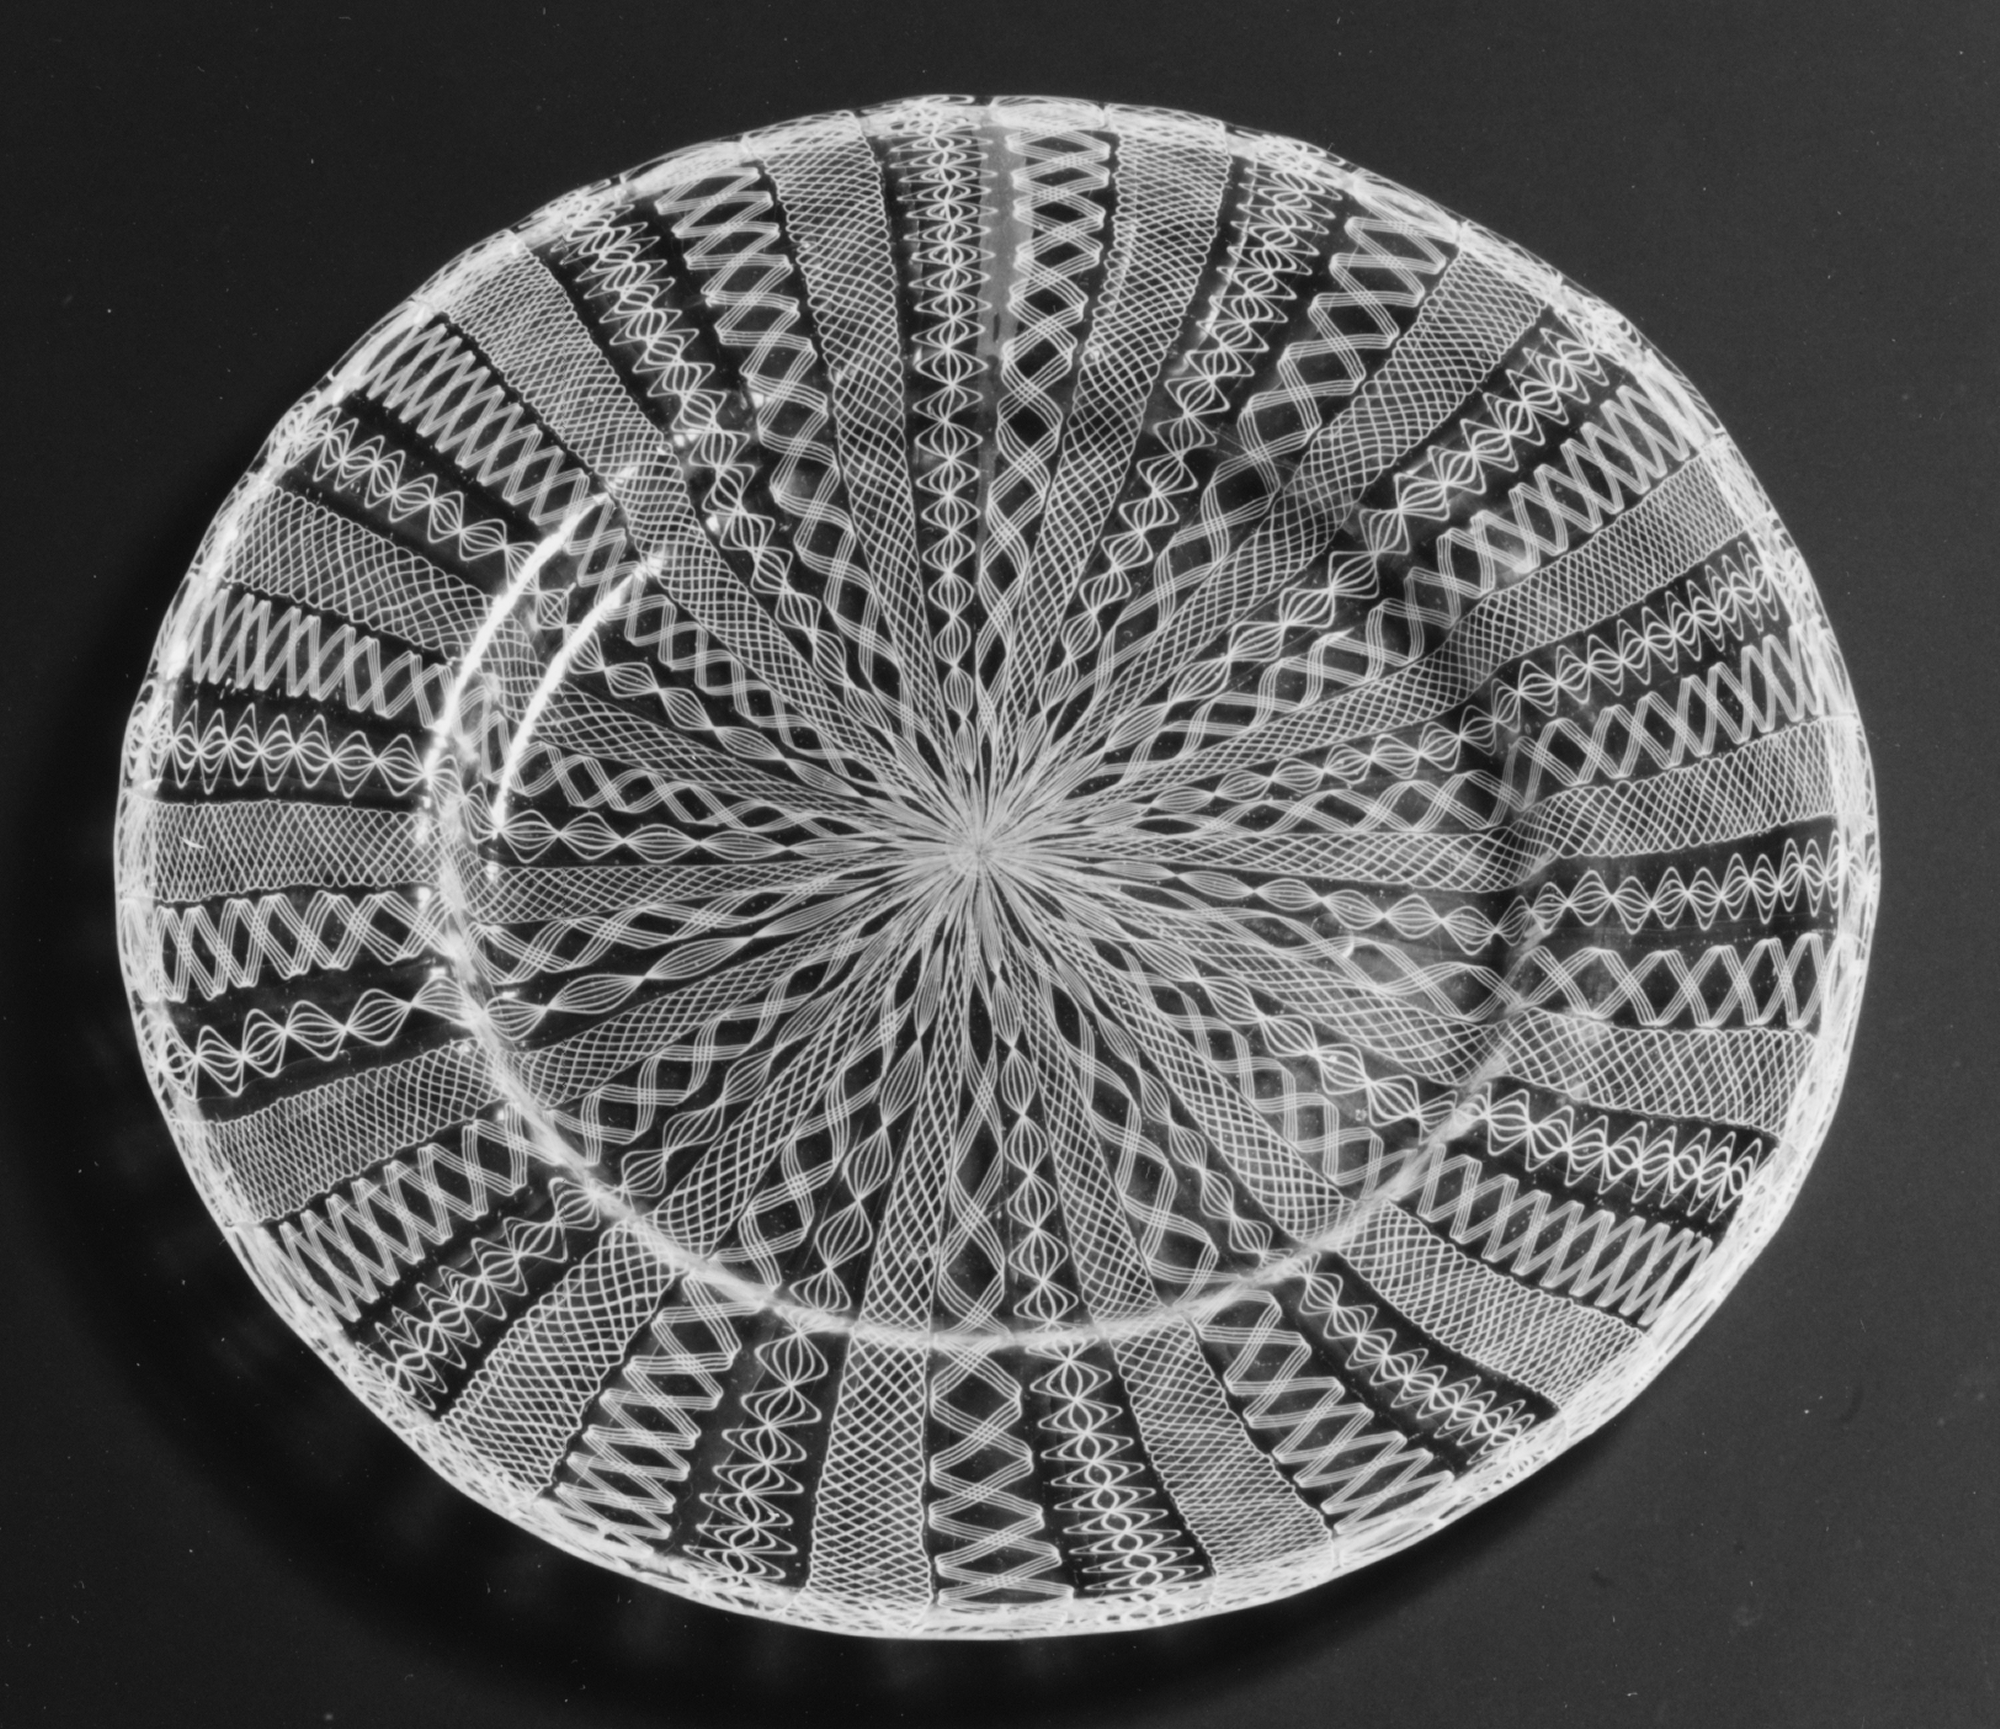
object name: plate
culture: italian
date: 1634-1733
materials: glass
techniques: glassblowing